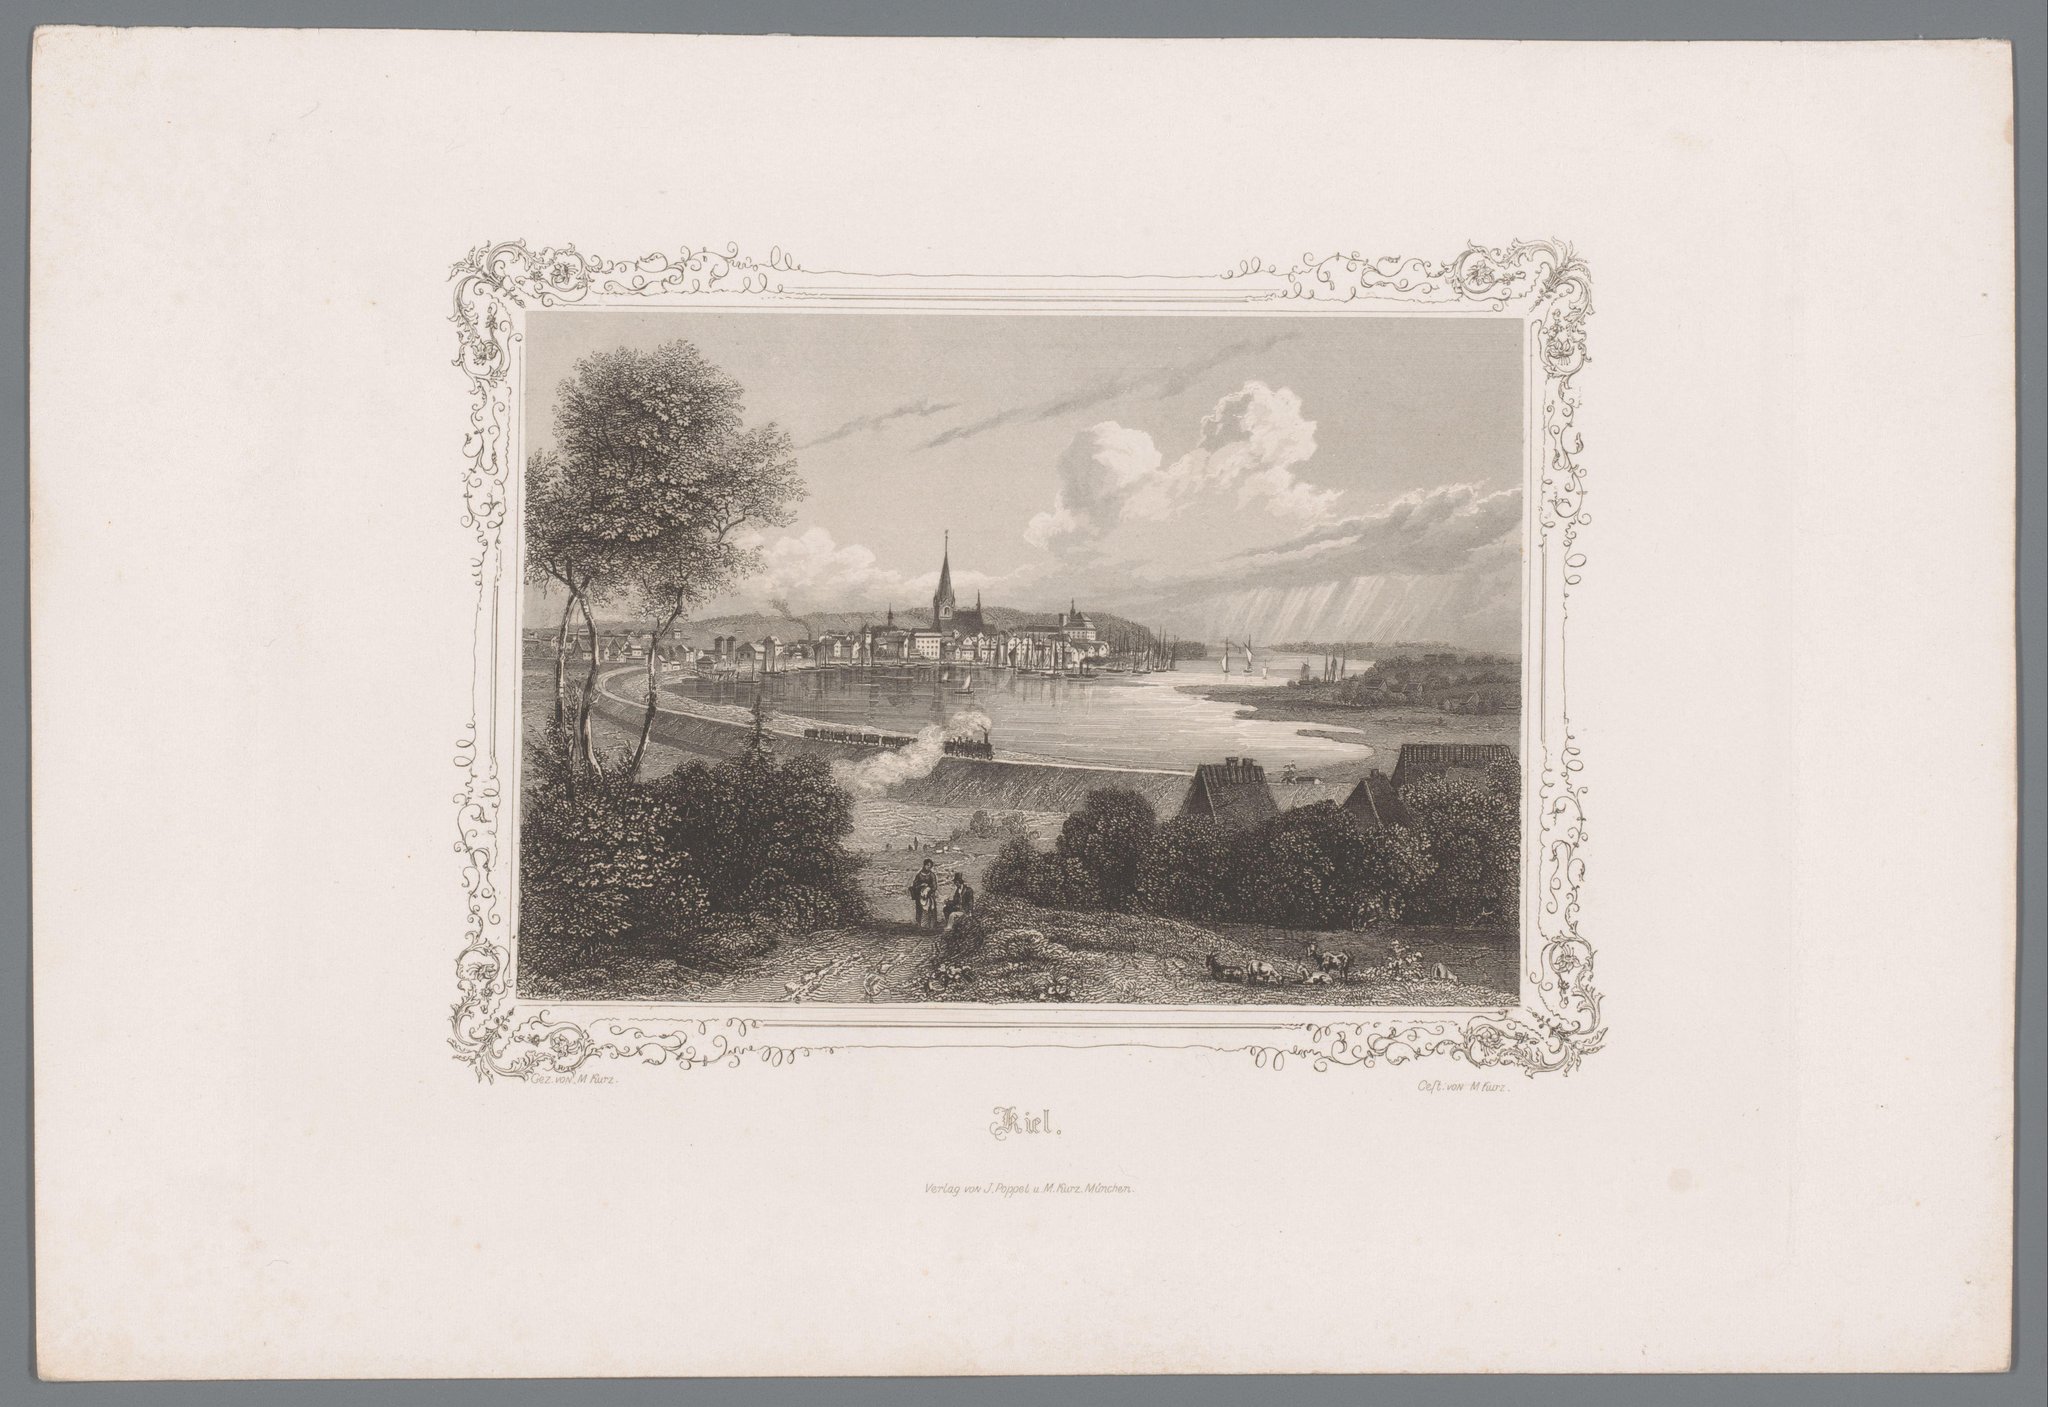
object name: print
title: Landschappen in Sleeswijk-Holstein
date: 1847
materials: paper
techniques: engraving, etching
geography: munich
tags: city-view in general; 'veduta' (+ city(-scape) with figures, staffage)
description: Deze prent behoort tot deel één of twee van de serie 'Landschappen in Sleeswijk-Holstein'. Het betreft een vierdelige reeks uitgegeven in twee omslagen waarvan deze omslag deel één en twee bevat met daarin zes landschappen en zes tekstbladen.